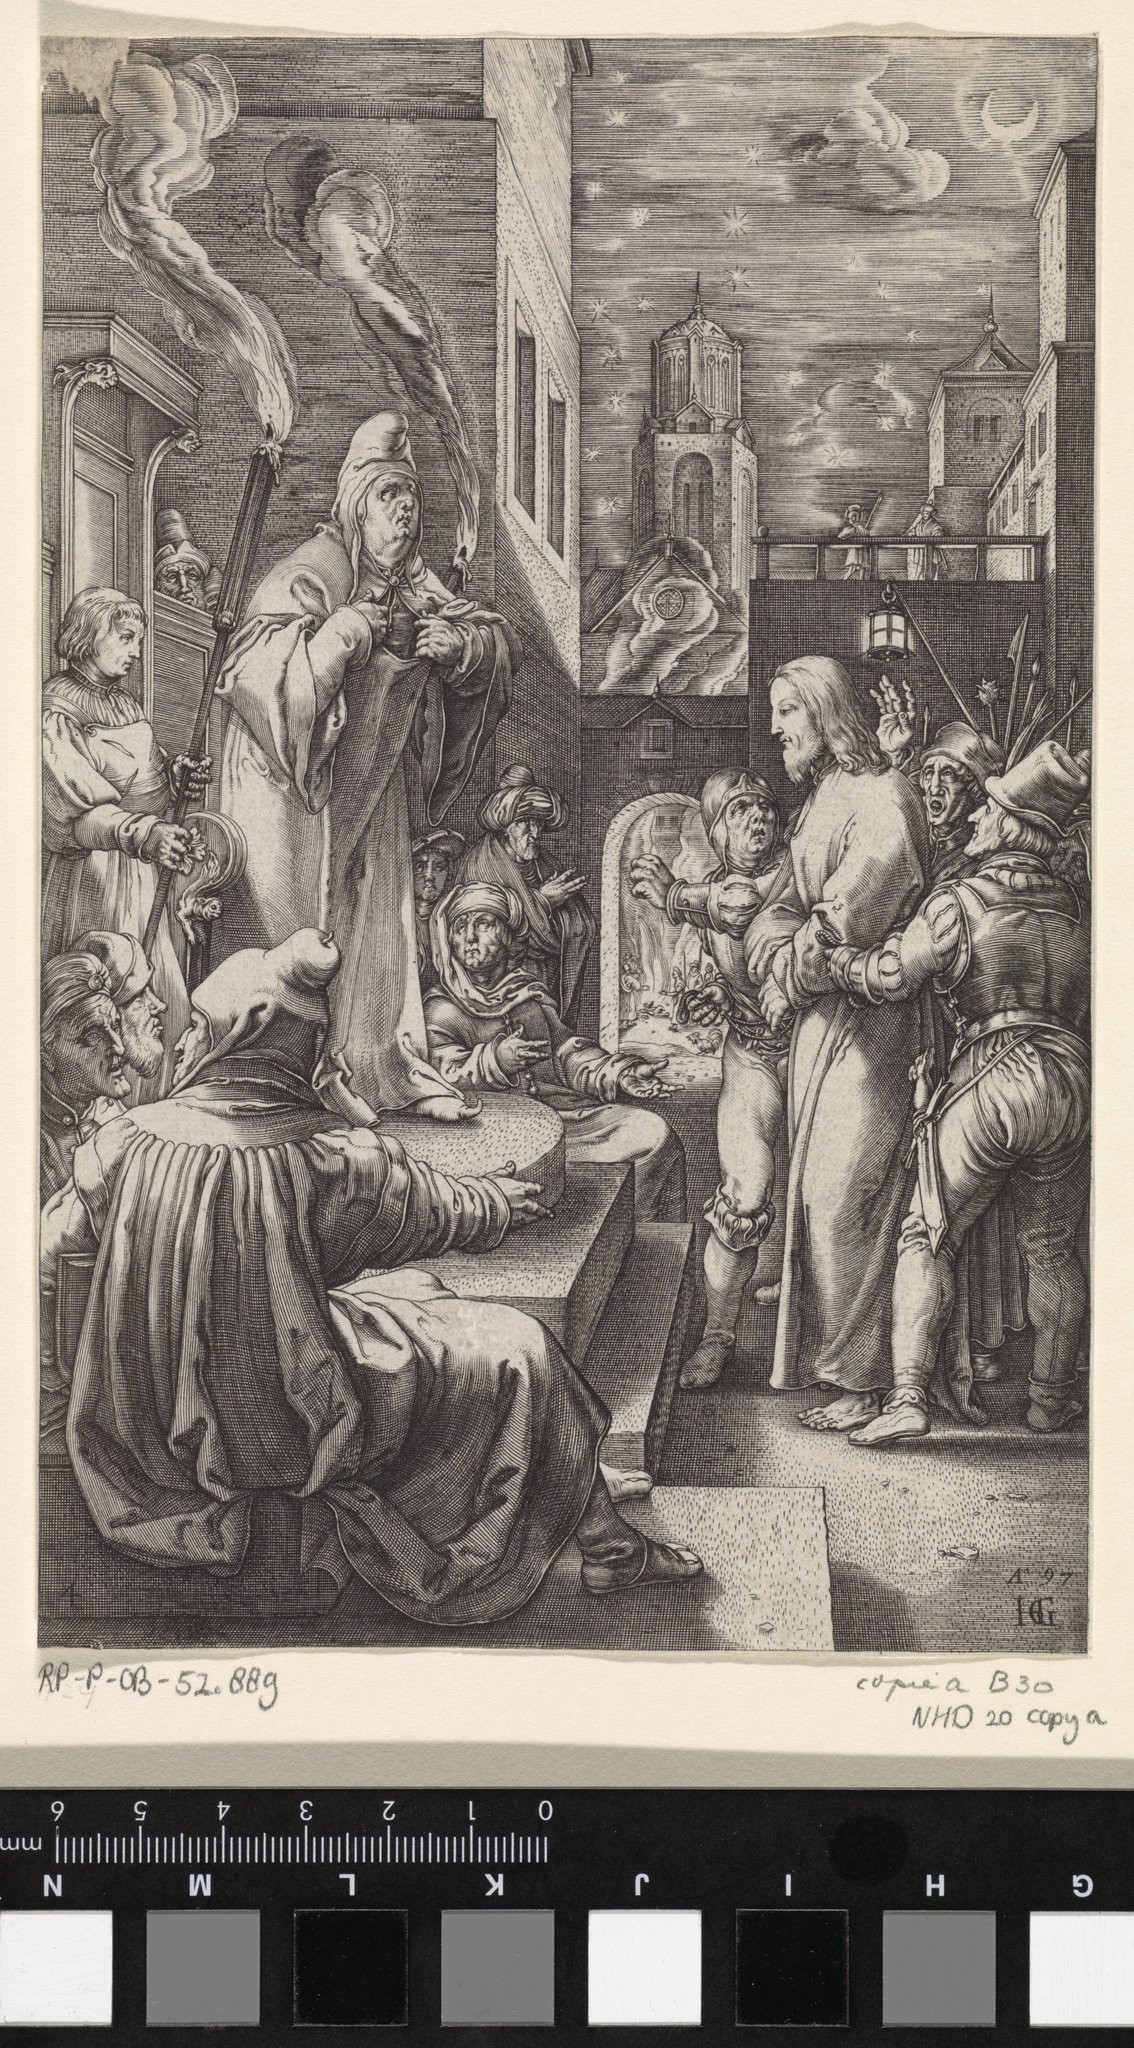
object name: print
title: De Passie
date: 1597-1667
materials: paper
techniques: engraving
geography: netherlands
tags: christ before the sanhedrin with caiaphas as high priest, and possibly annas; maybe a soldier about to strike christ because he keeps silent (matthew 26:57-66; mark 14:53-64; luke 22:54, 22:66-71)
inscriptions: collector's mark: Lugt 2228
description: Christus wordt voorgeleid aan de hogepriester Kajafas. Kajafas staat op een verhoging tussen twee fakkels en scheurt zijn kleed. Door de poort is het vuur op de binnenplaats zichtbaar waar Petrus zit.